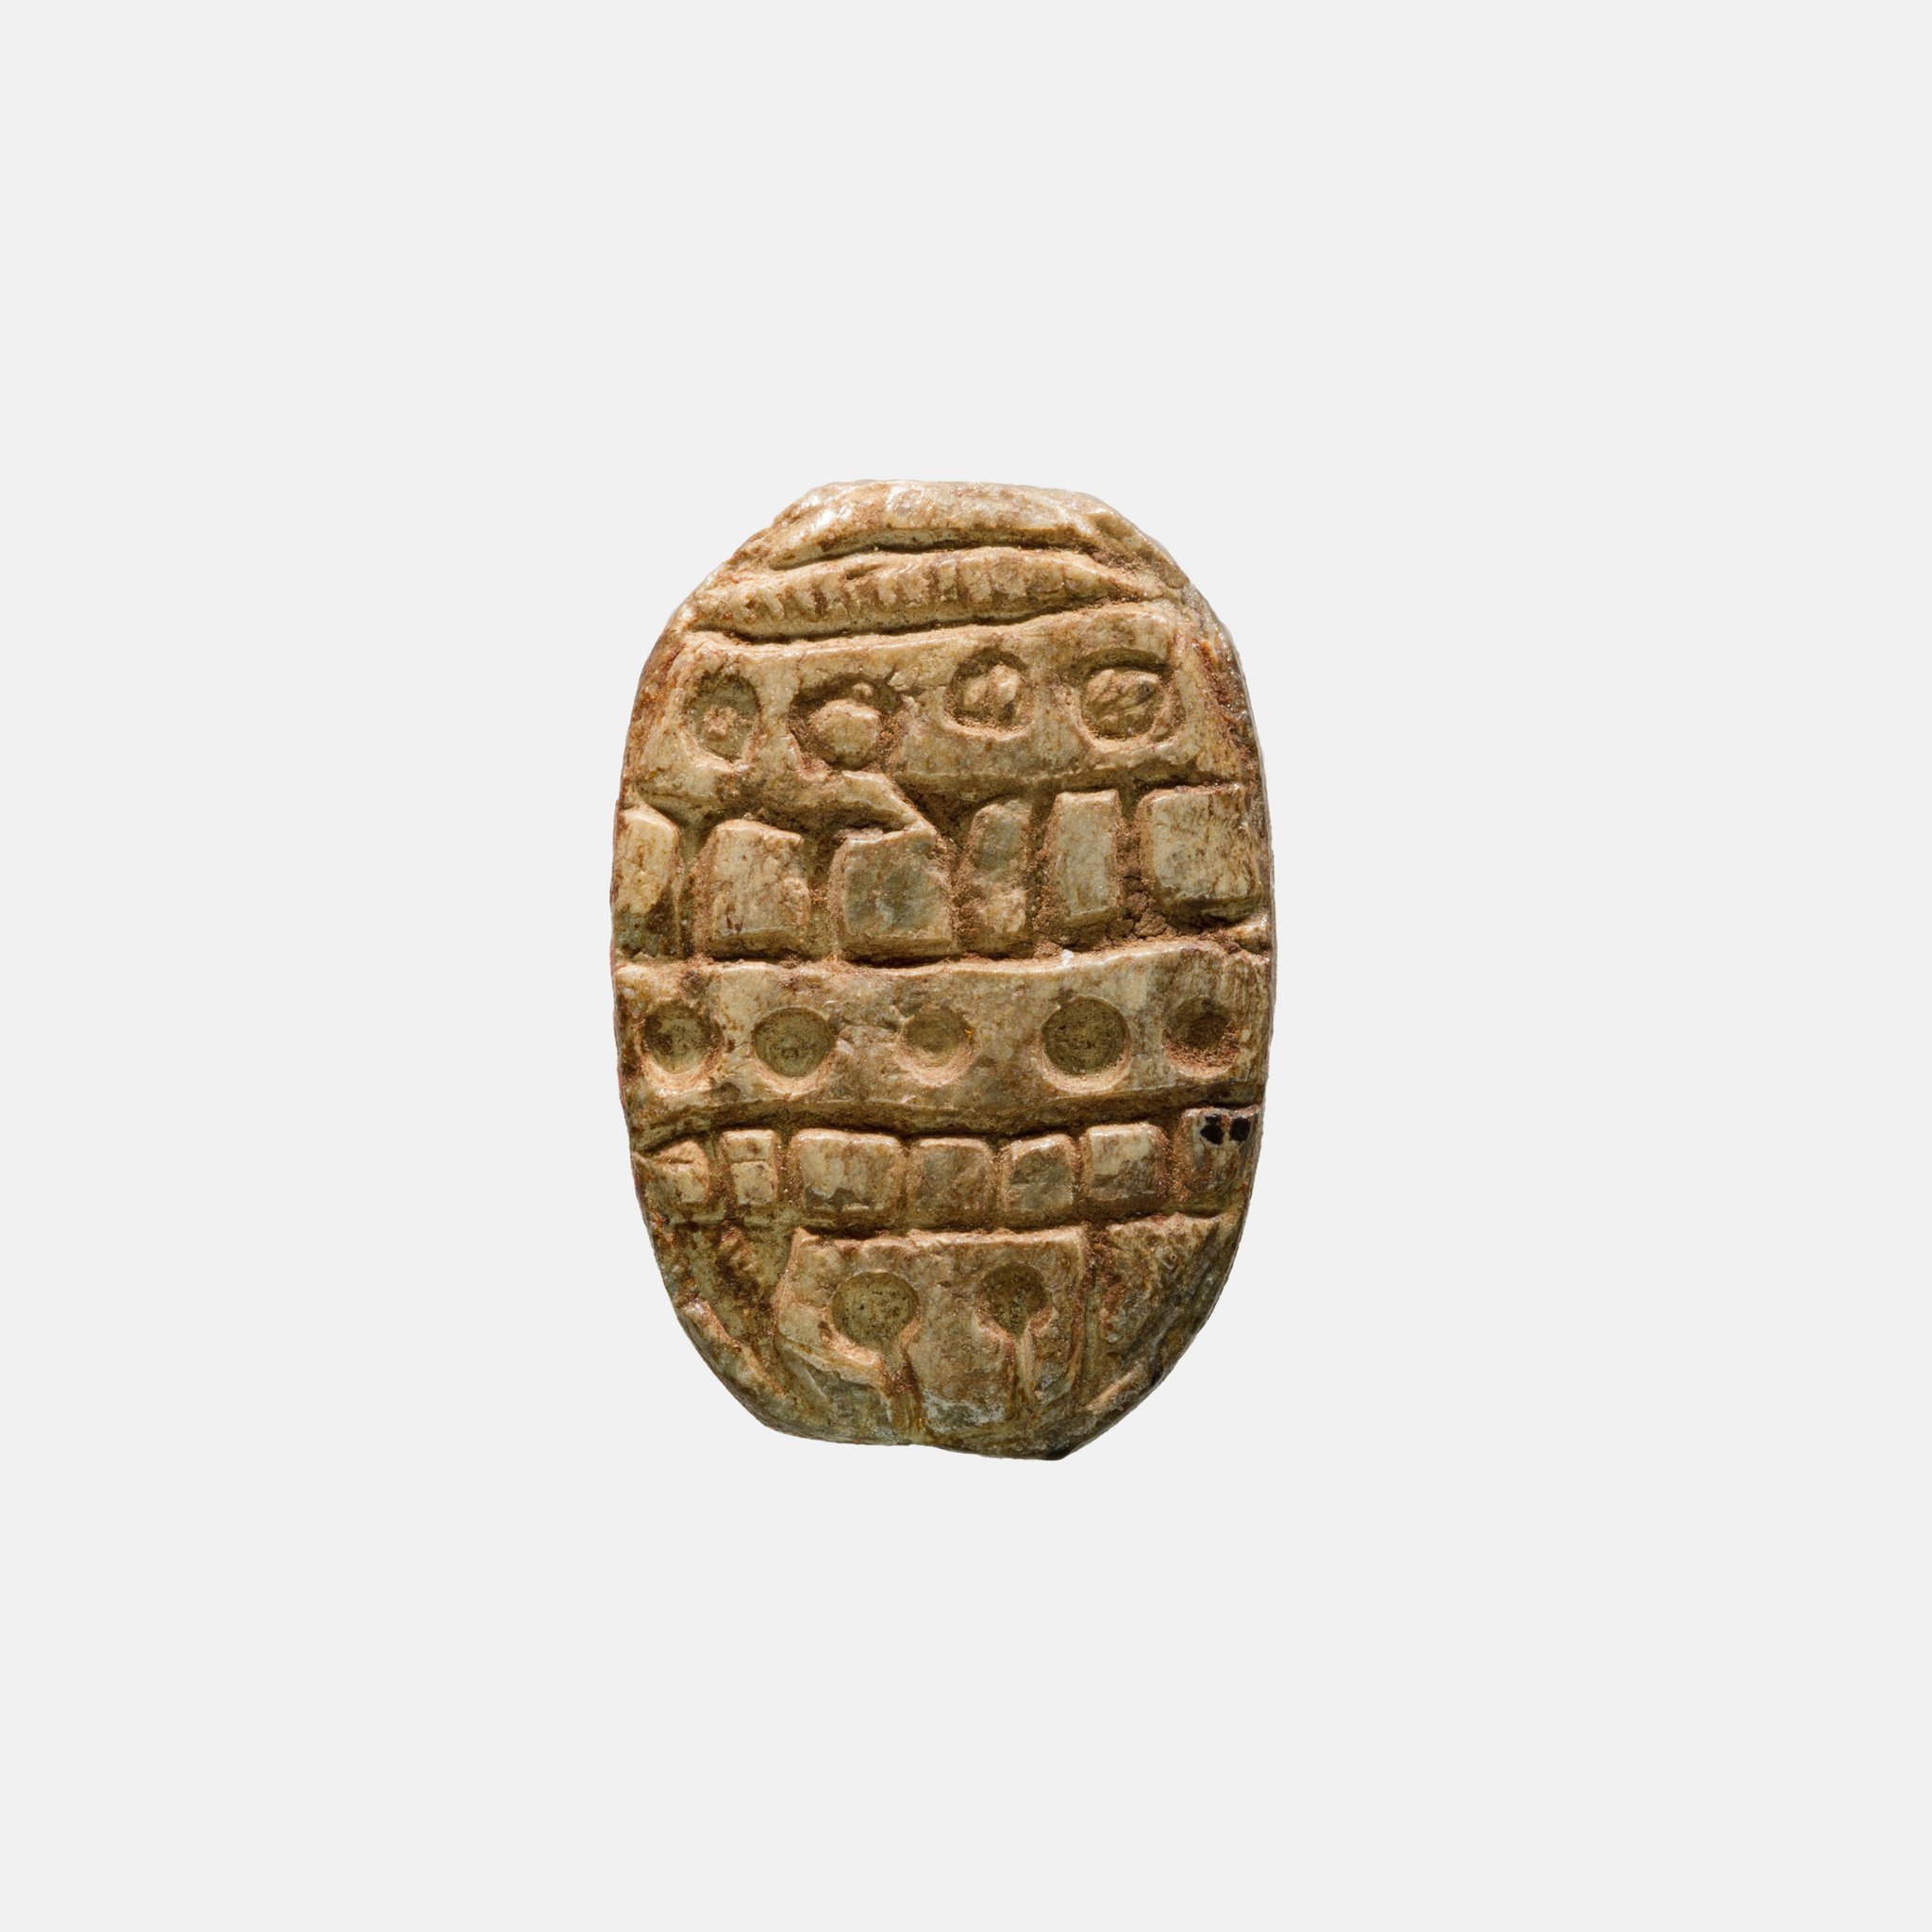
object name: cowroid, ruiu, ankhs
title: Cowroid Stamp Seal from Ruiu's Burial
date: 1504-1447 BCE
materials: stone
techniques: glazing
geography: egypt